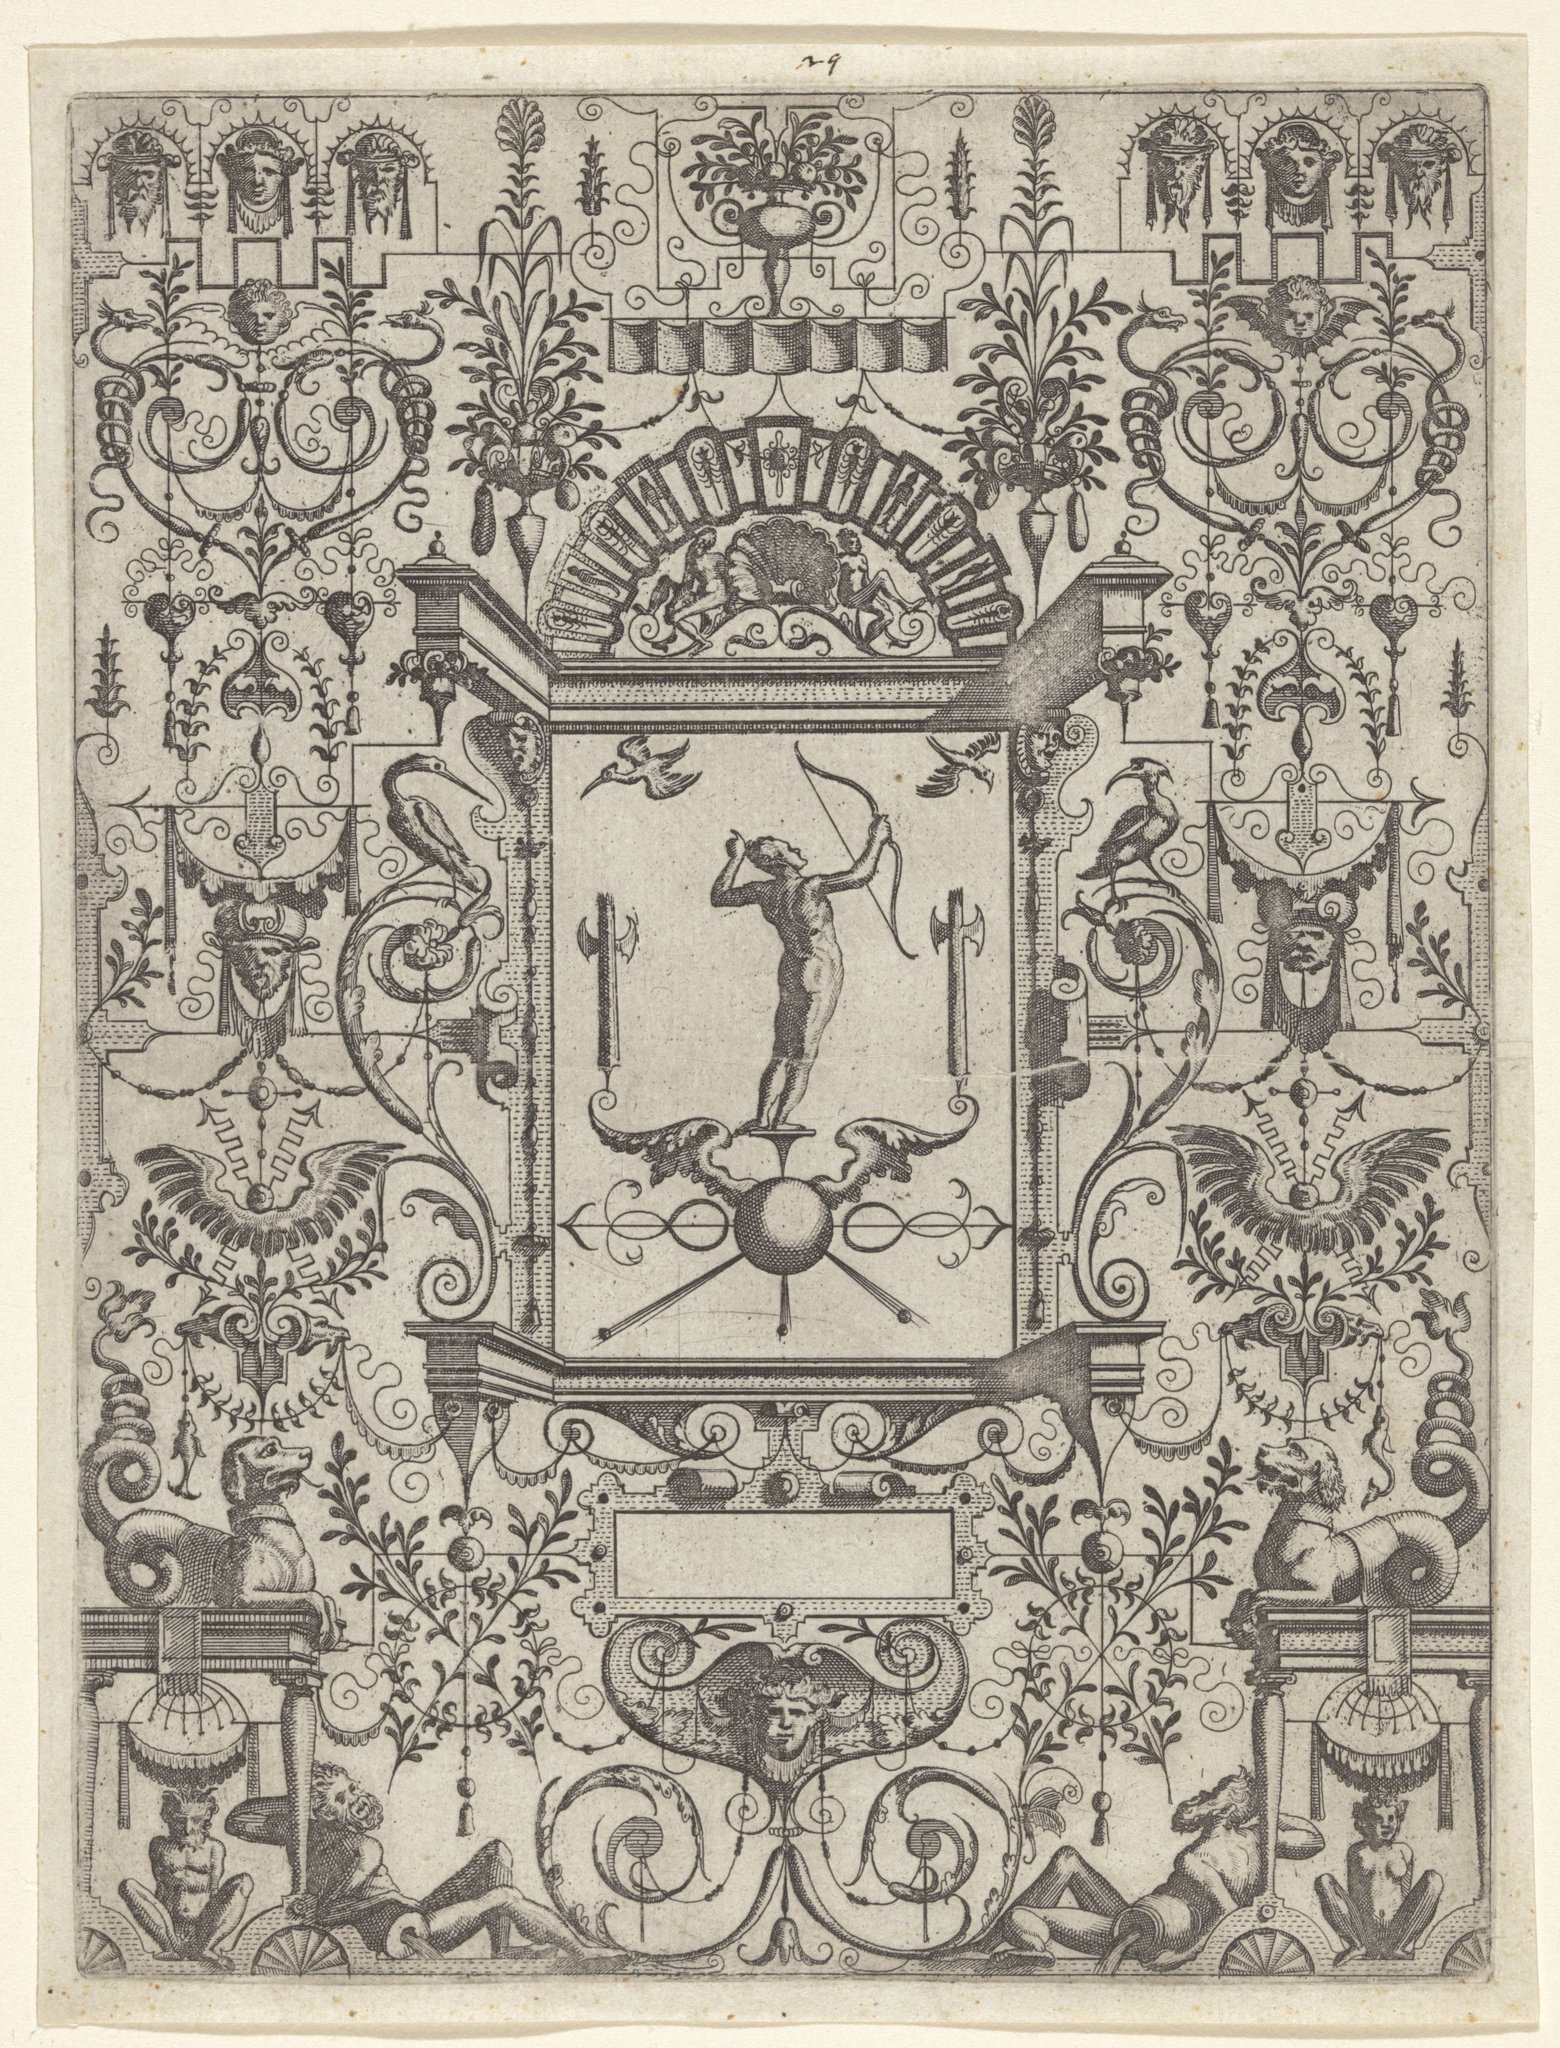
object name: ornament print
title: Grottesco: in diversche manieren…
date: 1565-1571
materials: paper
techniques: etching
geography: netherlands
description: Man, geflankeerd door fasces, staand op een gevleugelde bol. Linksonder en rechtsonder zit een gehurkte figuur onder een baldakijn waarop een hond met een vissenstaart ligt. Uit serie van titelblad + 16 bladen met cartouches of architectuurfantasieën met een voorstelling in een omlijsting van grotesken met fabelwezens, dieren, guirlandes, trofeeën en mascarons.